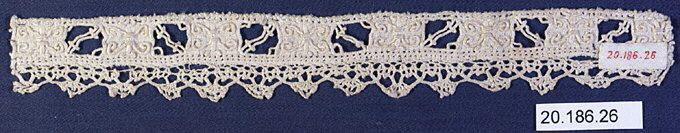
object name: strip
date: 1501-1600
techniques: embroidery